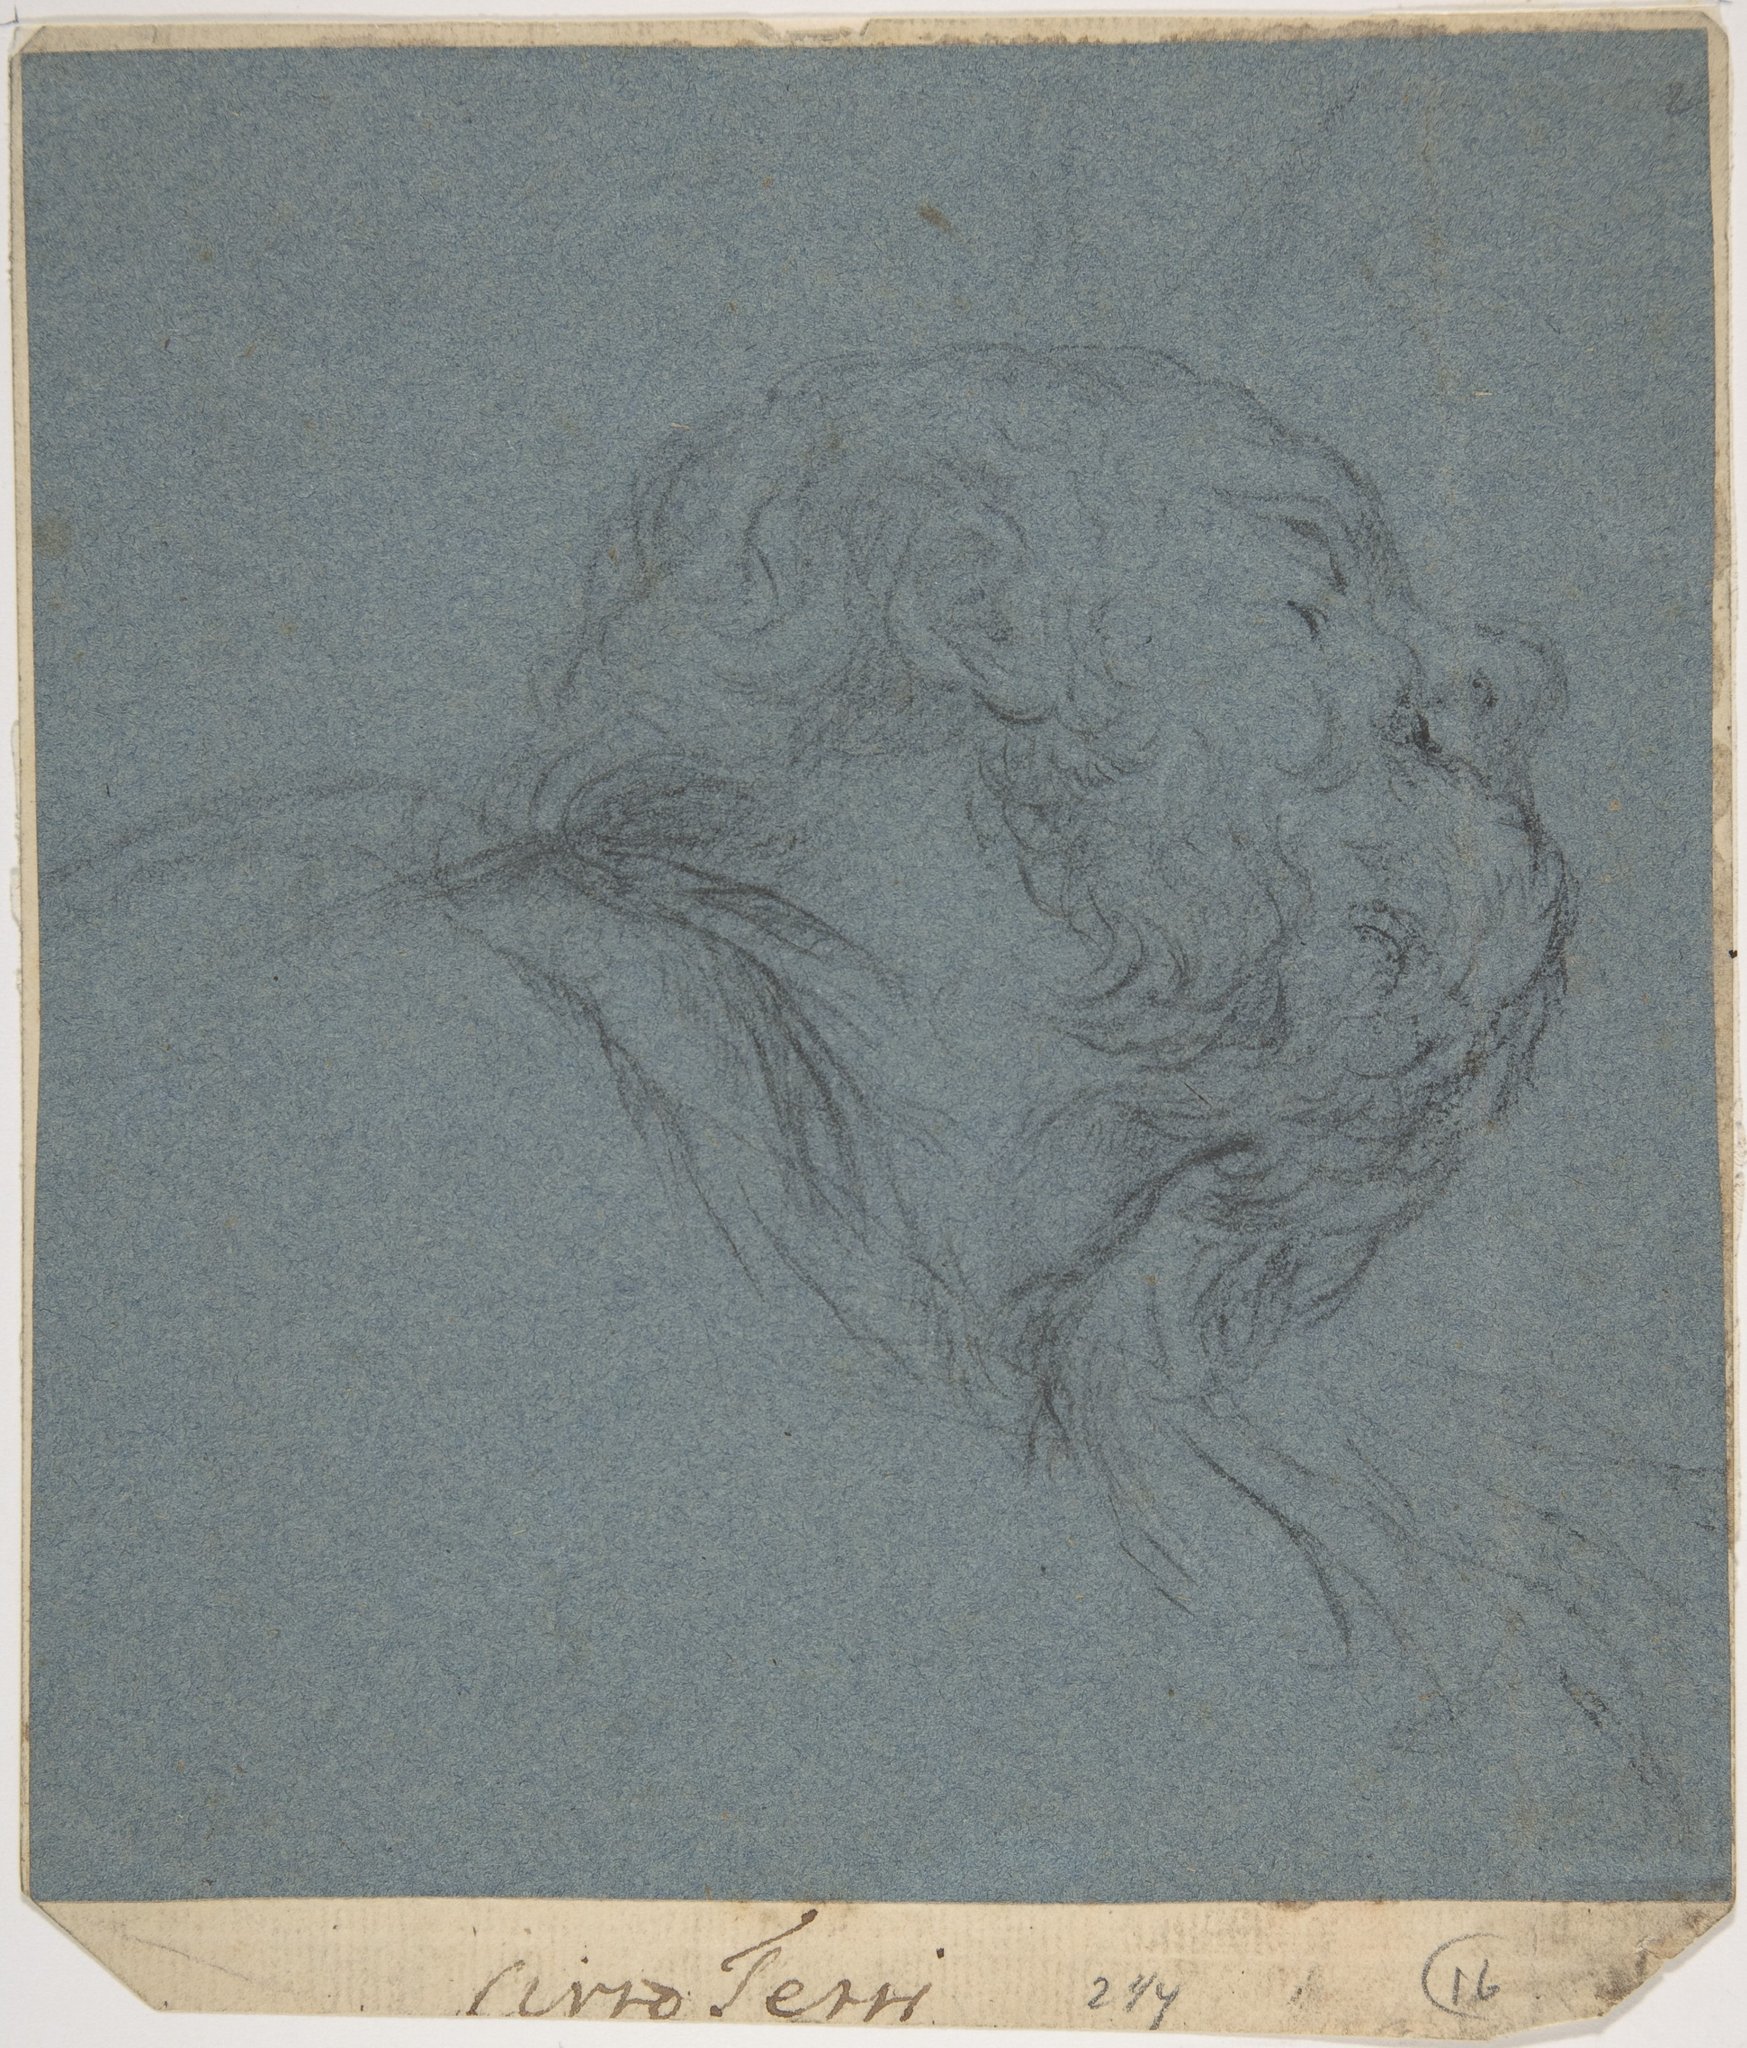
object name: drawing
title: Head of a Bearded Man Looking to Upper Right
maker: ciro ferri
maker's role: artist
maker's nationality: italian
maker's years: 1634-1689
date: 1634-1689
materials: chalk, paper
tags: men,profiles